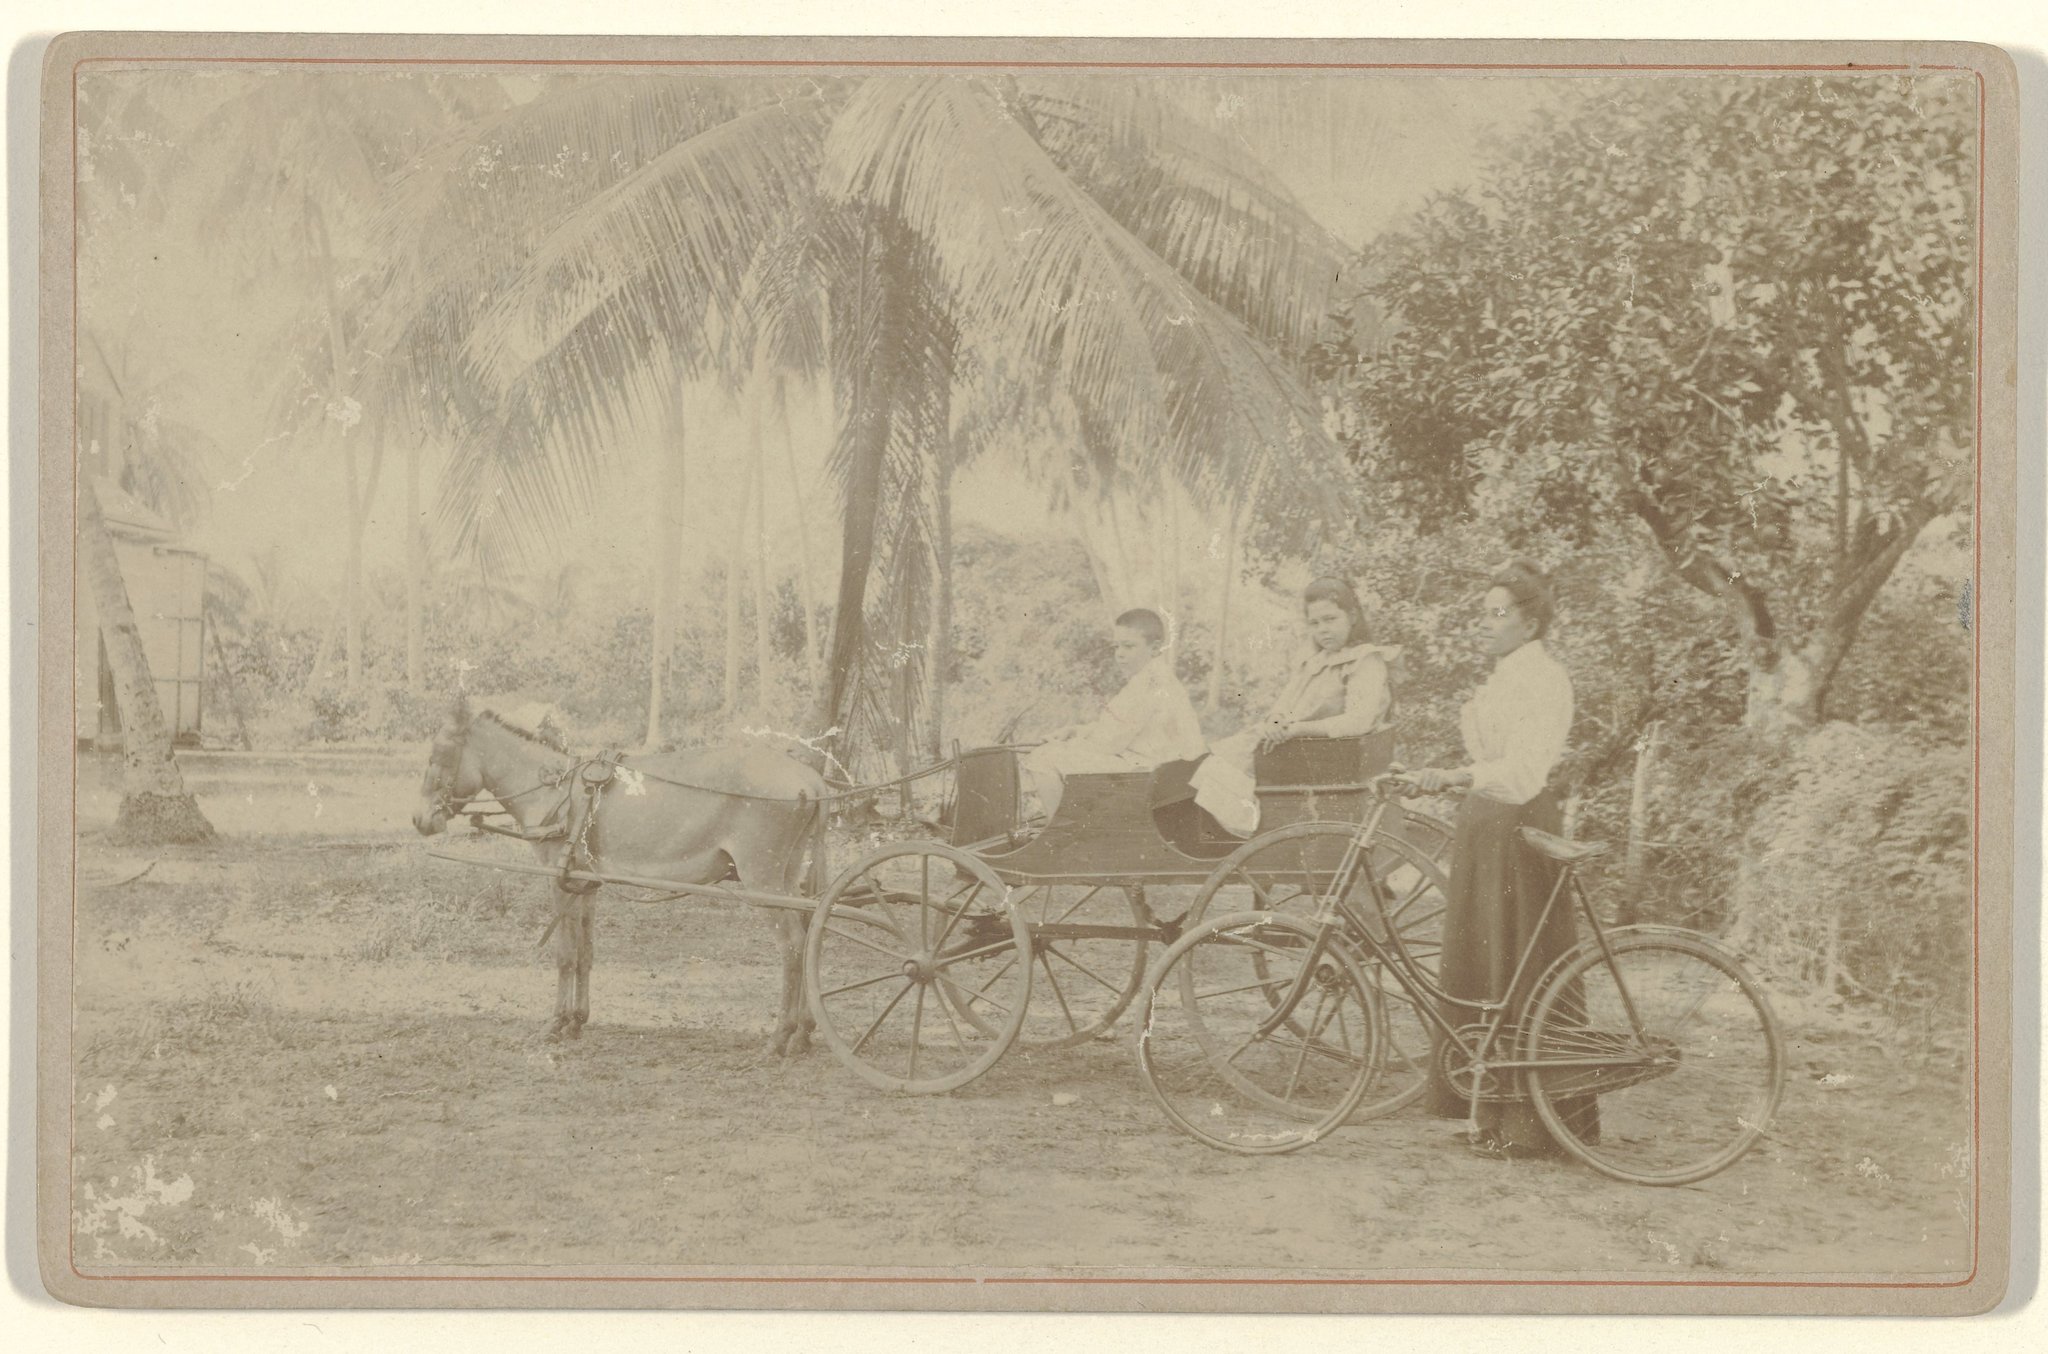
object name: photograph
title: Tante Jacqueline Wesenhagen met Wilhelm en Frieda Wesenhagen, kinderen van Jacob Evert Wesenhagen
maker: jacob evert wesenhagen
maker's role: amateurfotograaf, arts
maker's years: 1862-1924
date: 1905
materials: cardboard, photographic support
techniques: photography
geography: suriname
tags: jacob evert wesenhagen, the hague, wilhelm martin wesenhagen, four-wheeled vehicle drawn by one animal, bicycle, suriname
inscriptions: annotation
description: Tante Jacqueline Wesenhagen met Wilhelm en Frieda Wesenhagen, kinderen van Jacob Evert Wesenhagen. De kinderen in een koets, de vrouw houdt een fiets vast. Onderdeel van een groep objecten afkomstig van de familie Wesenhagen in Suriname.